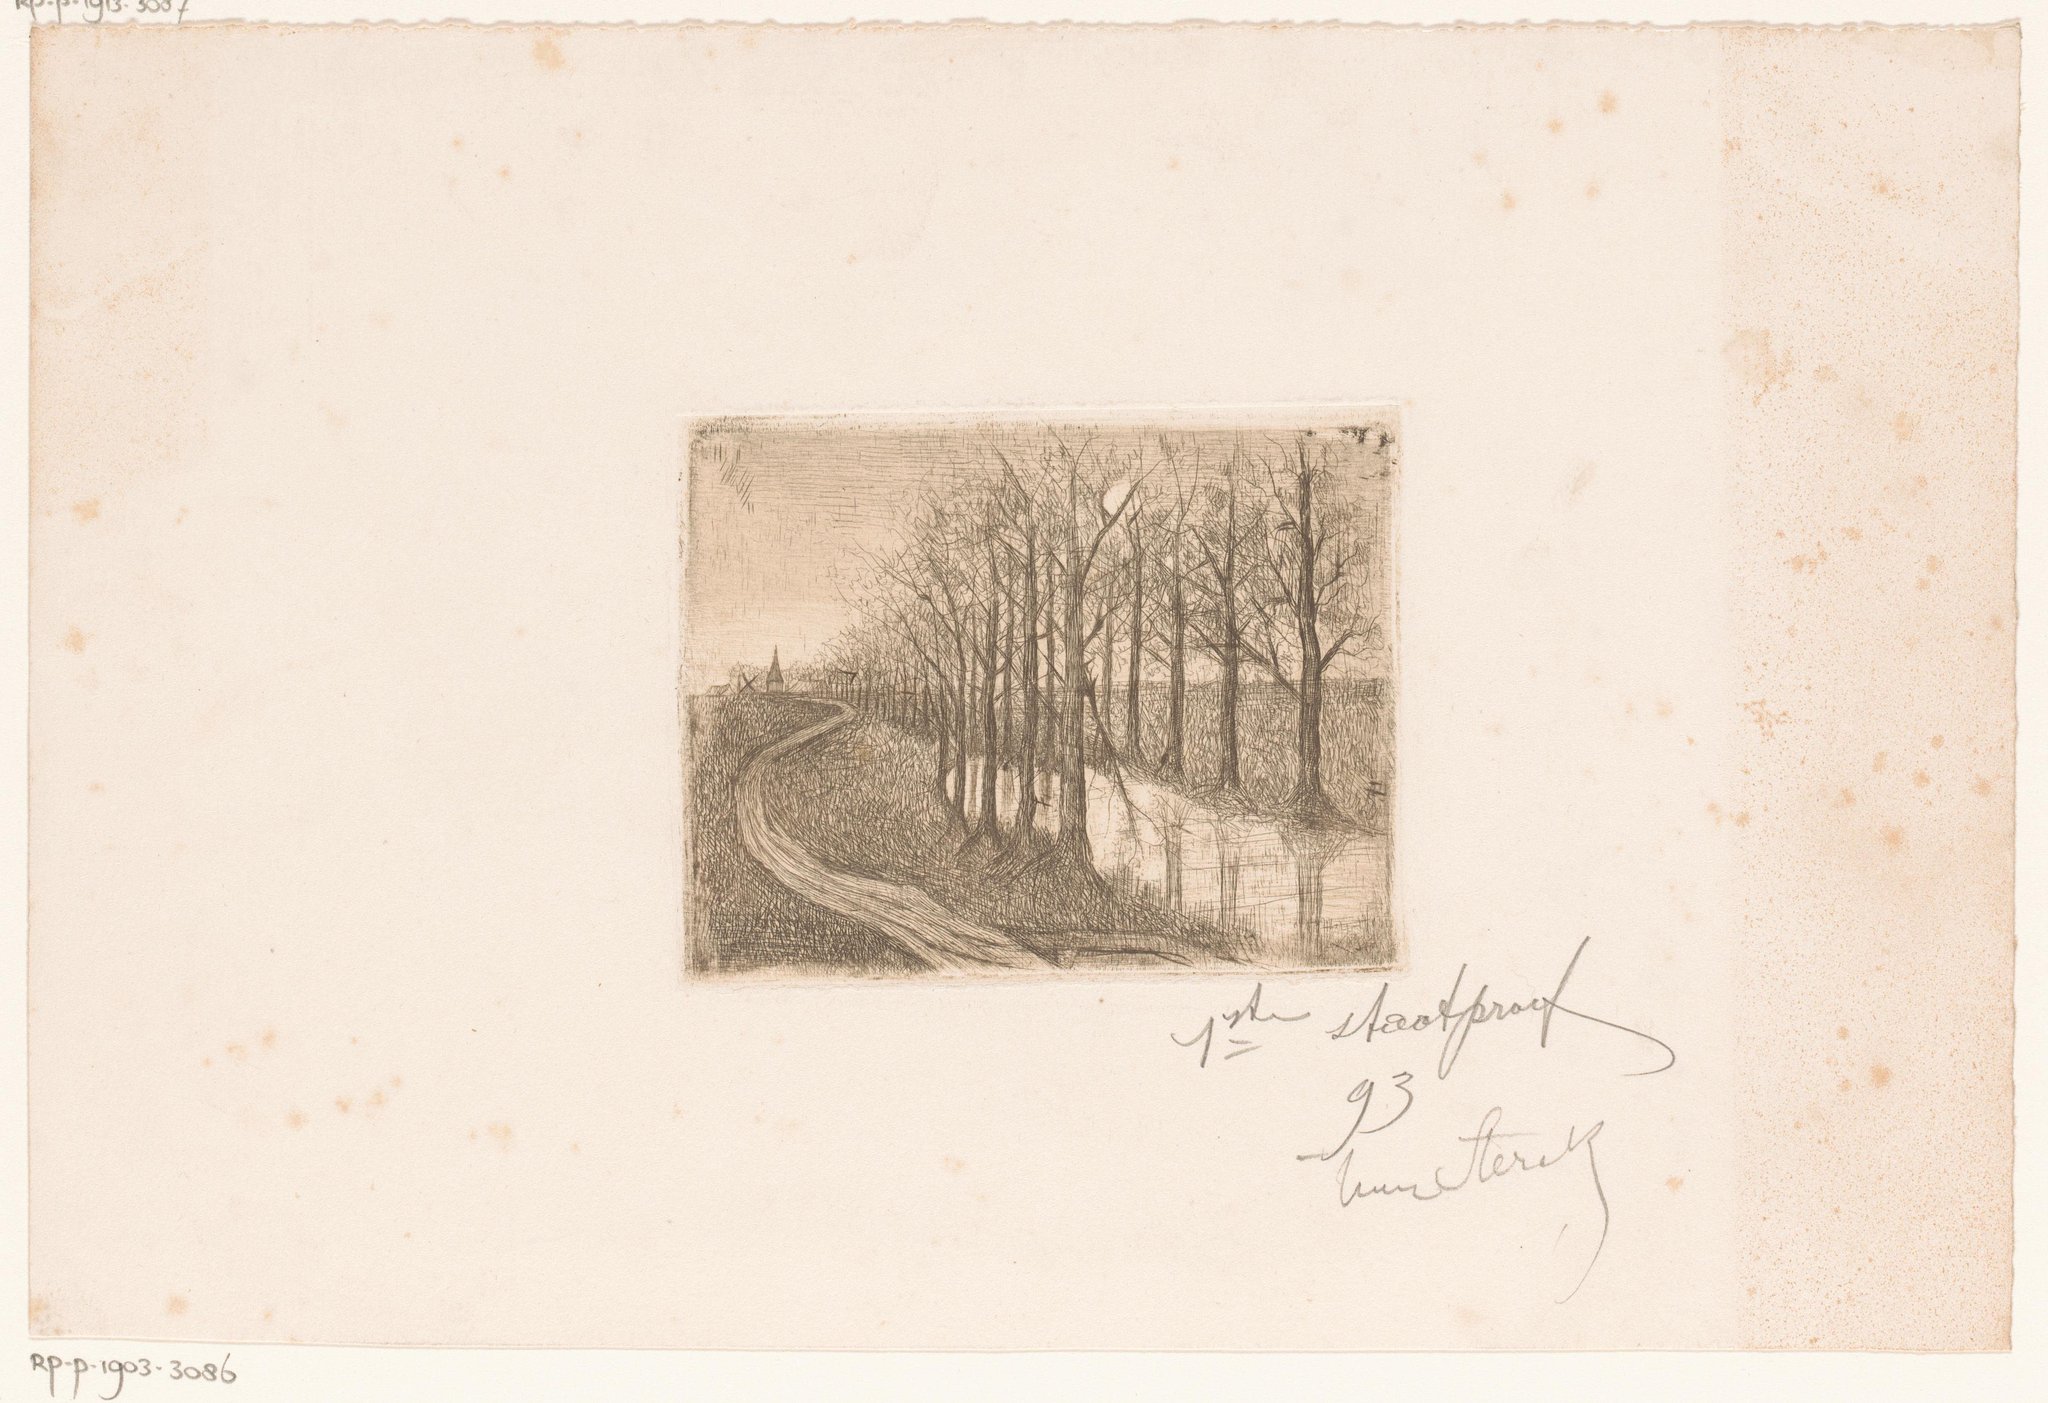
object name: print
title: Nachtelijk landschap met bomenrij langs kanaal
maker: arthur sterck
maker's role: print maker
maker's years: 1868-1897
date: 1893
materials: paper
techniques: etching, intaglio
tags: prospect of village, silhouette of village, full moon, canal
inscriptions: annotation: ‘1ste staatproef’, collector's mark: Lugt 2228